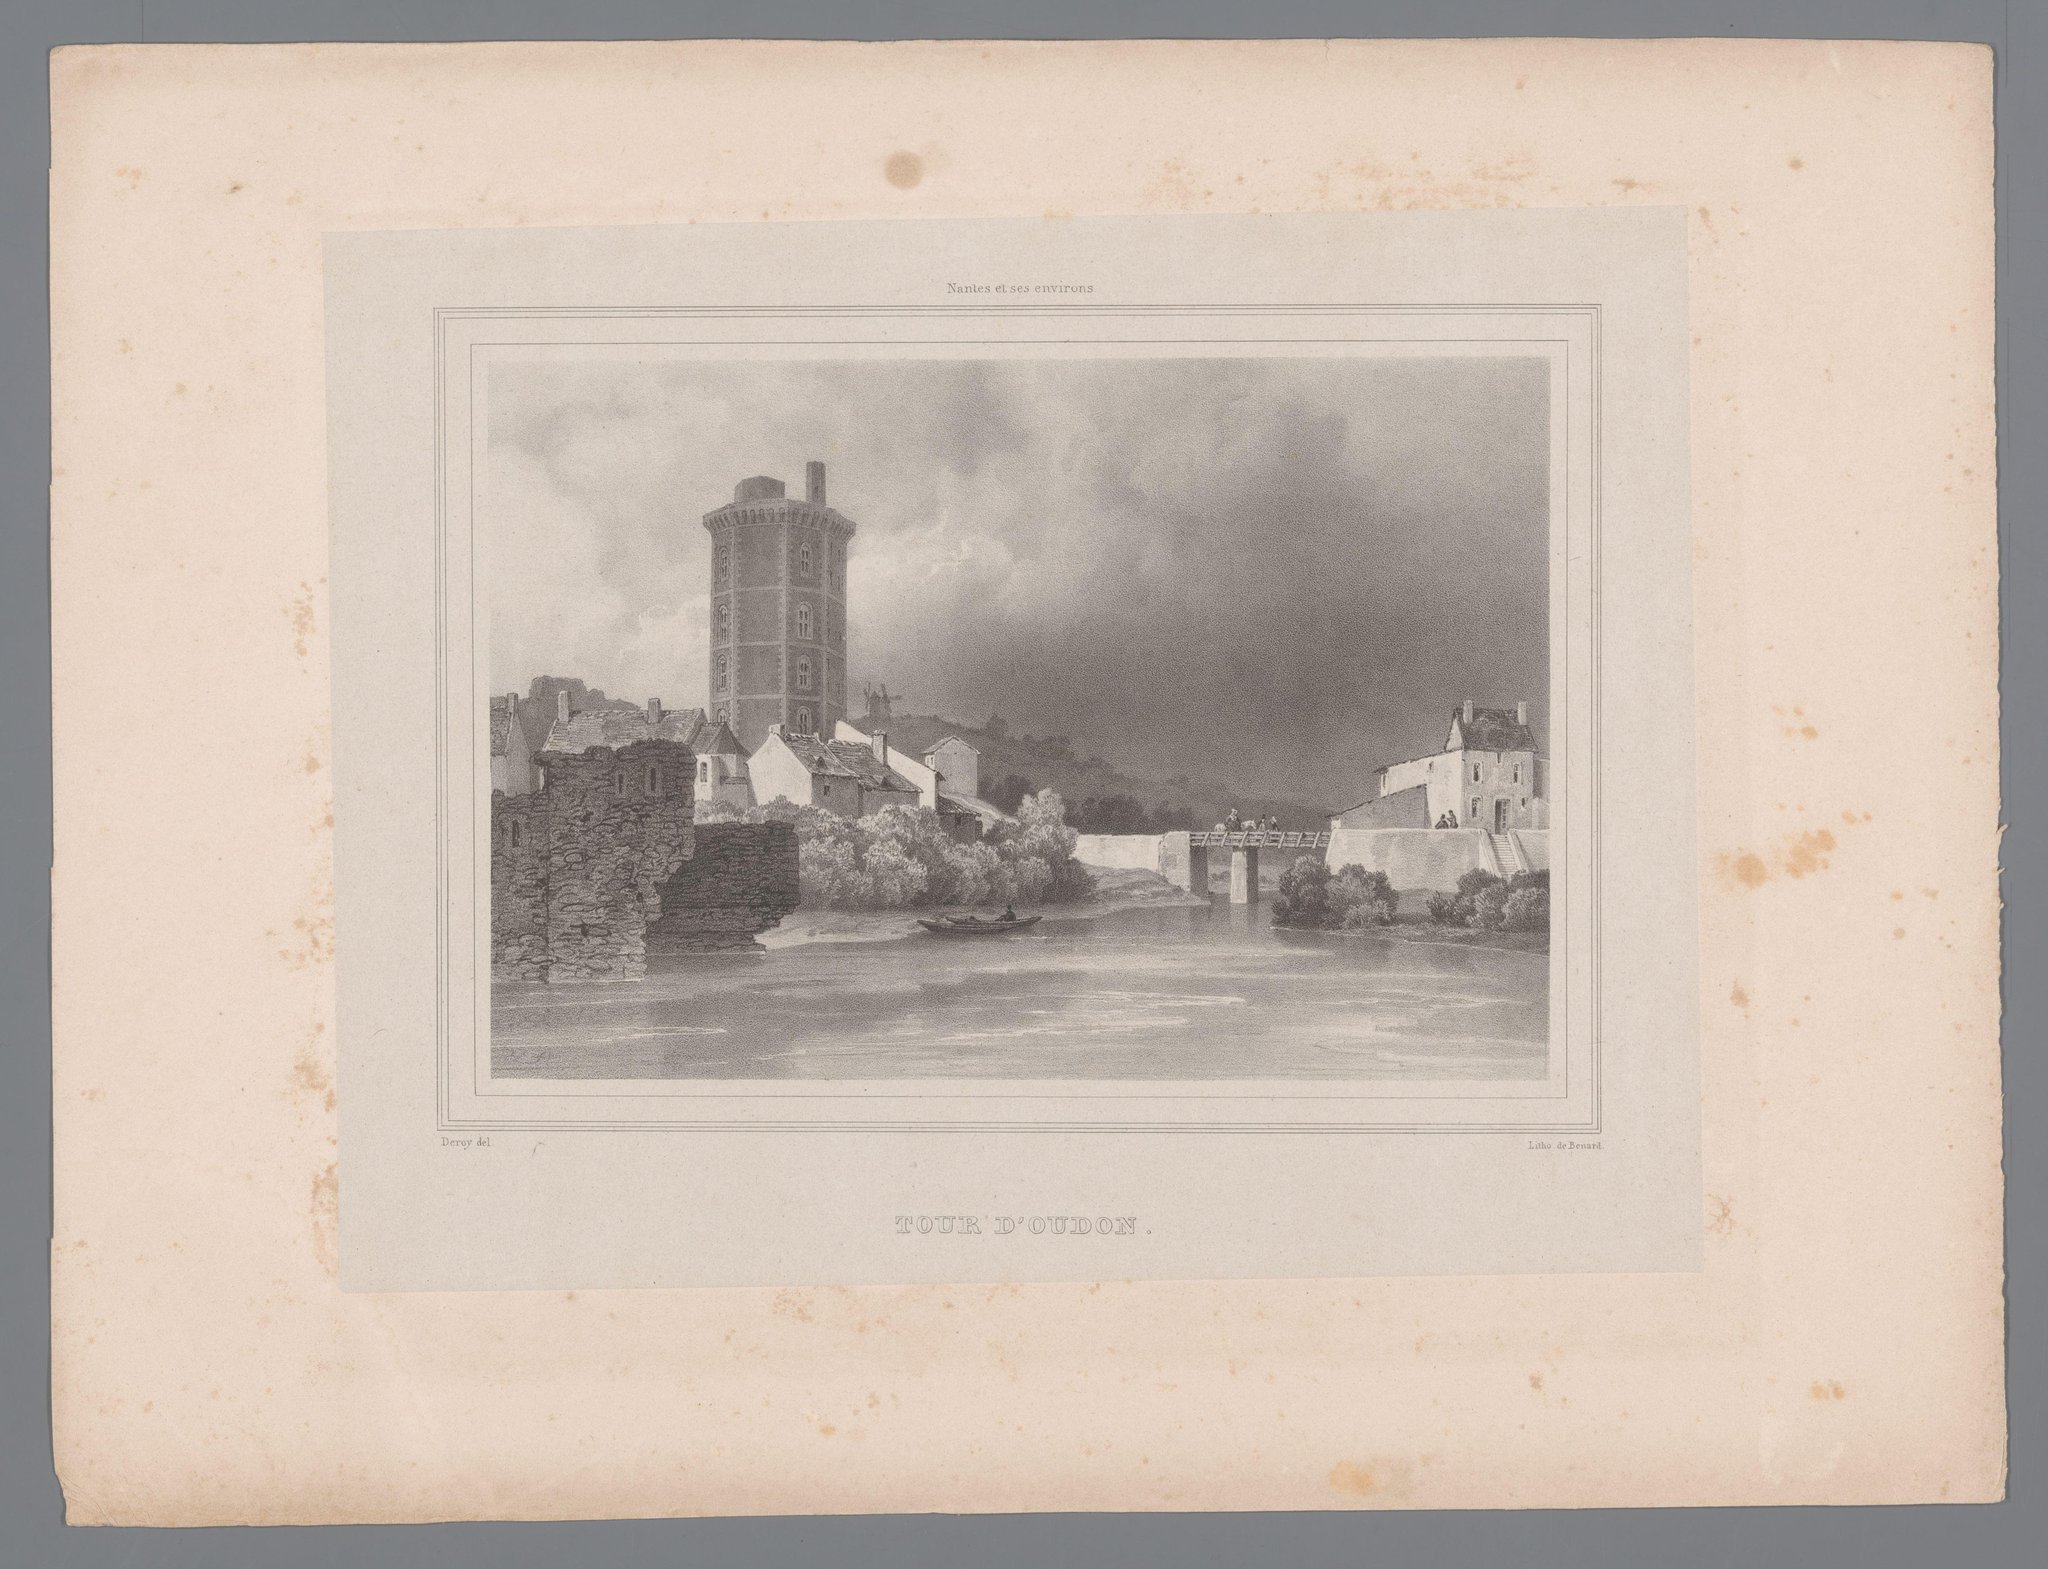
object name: print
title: Tour d'Oudon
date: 1833-1835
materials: paper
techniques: lithograph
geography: oudon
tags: castle, bridge in city across river, canal, etc., river (+ landscape with figures, staffage), prospect of city, town panorama, silhouette of city (+ city(-scape) with figures, staffage)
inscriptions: collector's mark: Lugt 2228a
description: Prent maakt deel uit van een omslag met achttien prenten.